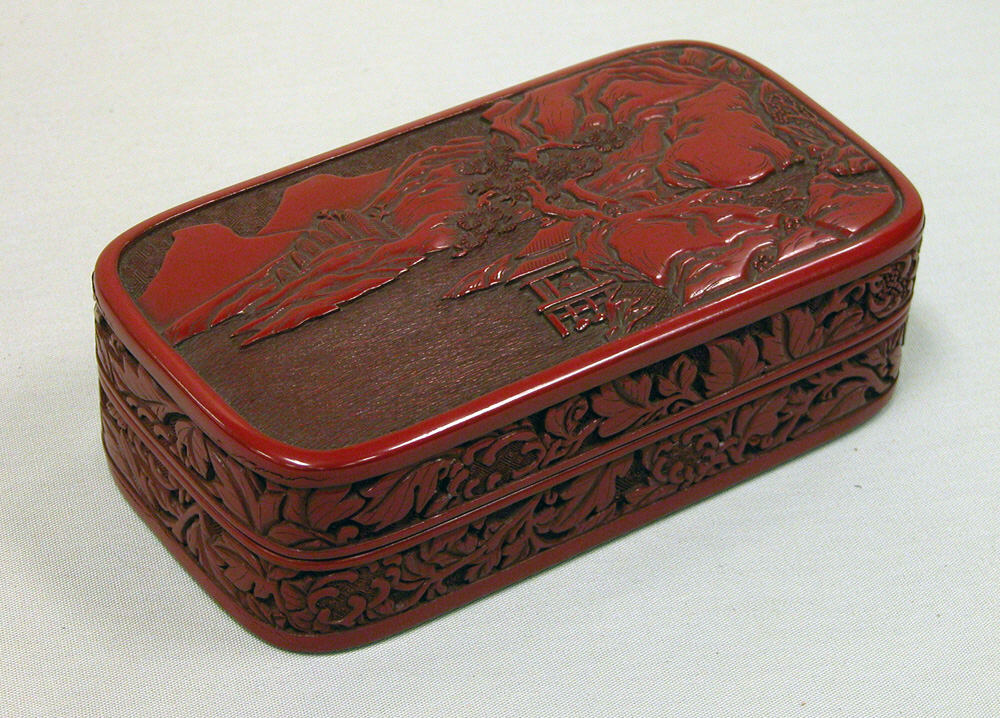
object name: box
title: Box with Landscape and Scroll Pattern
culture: japanese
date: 1615-1868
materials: lacquer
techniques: carving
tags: landscapes,leaves